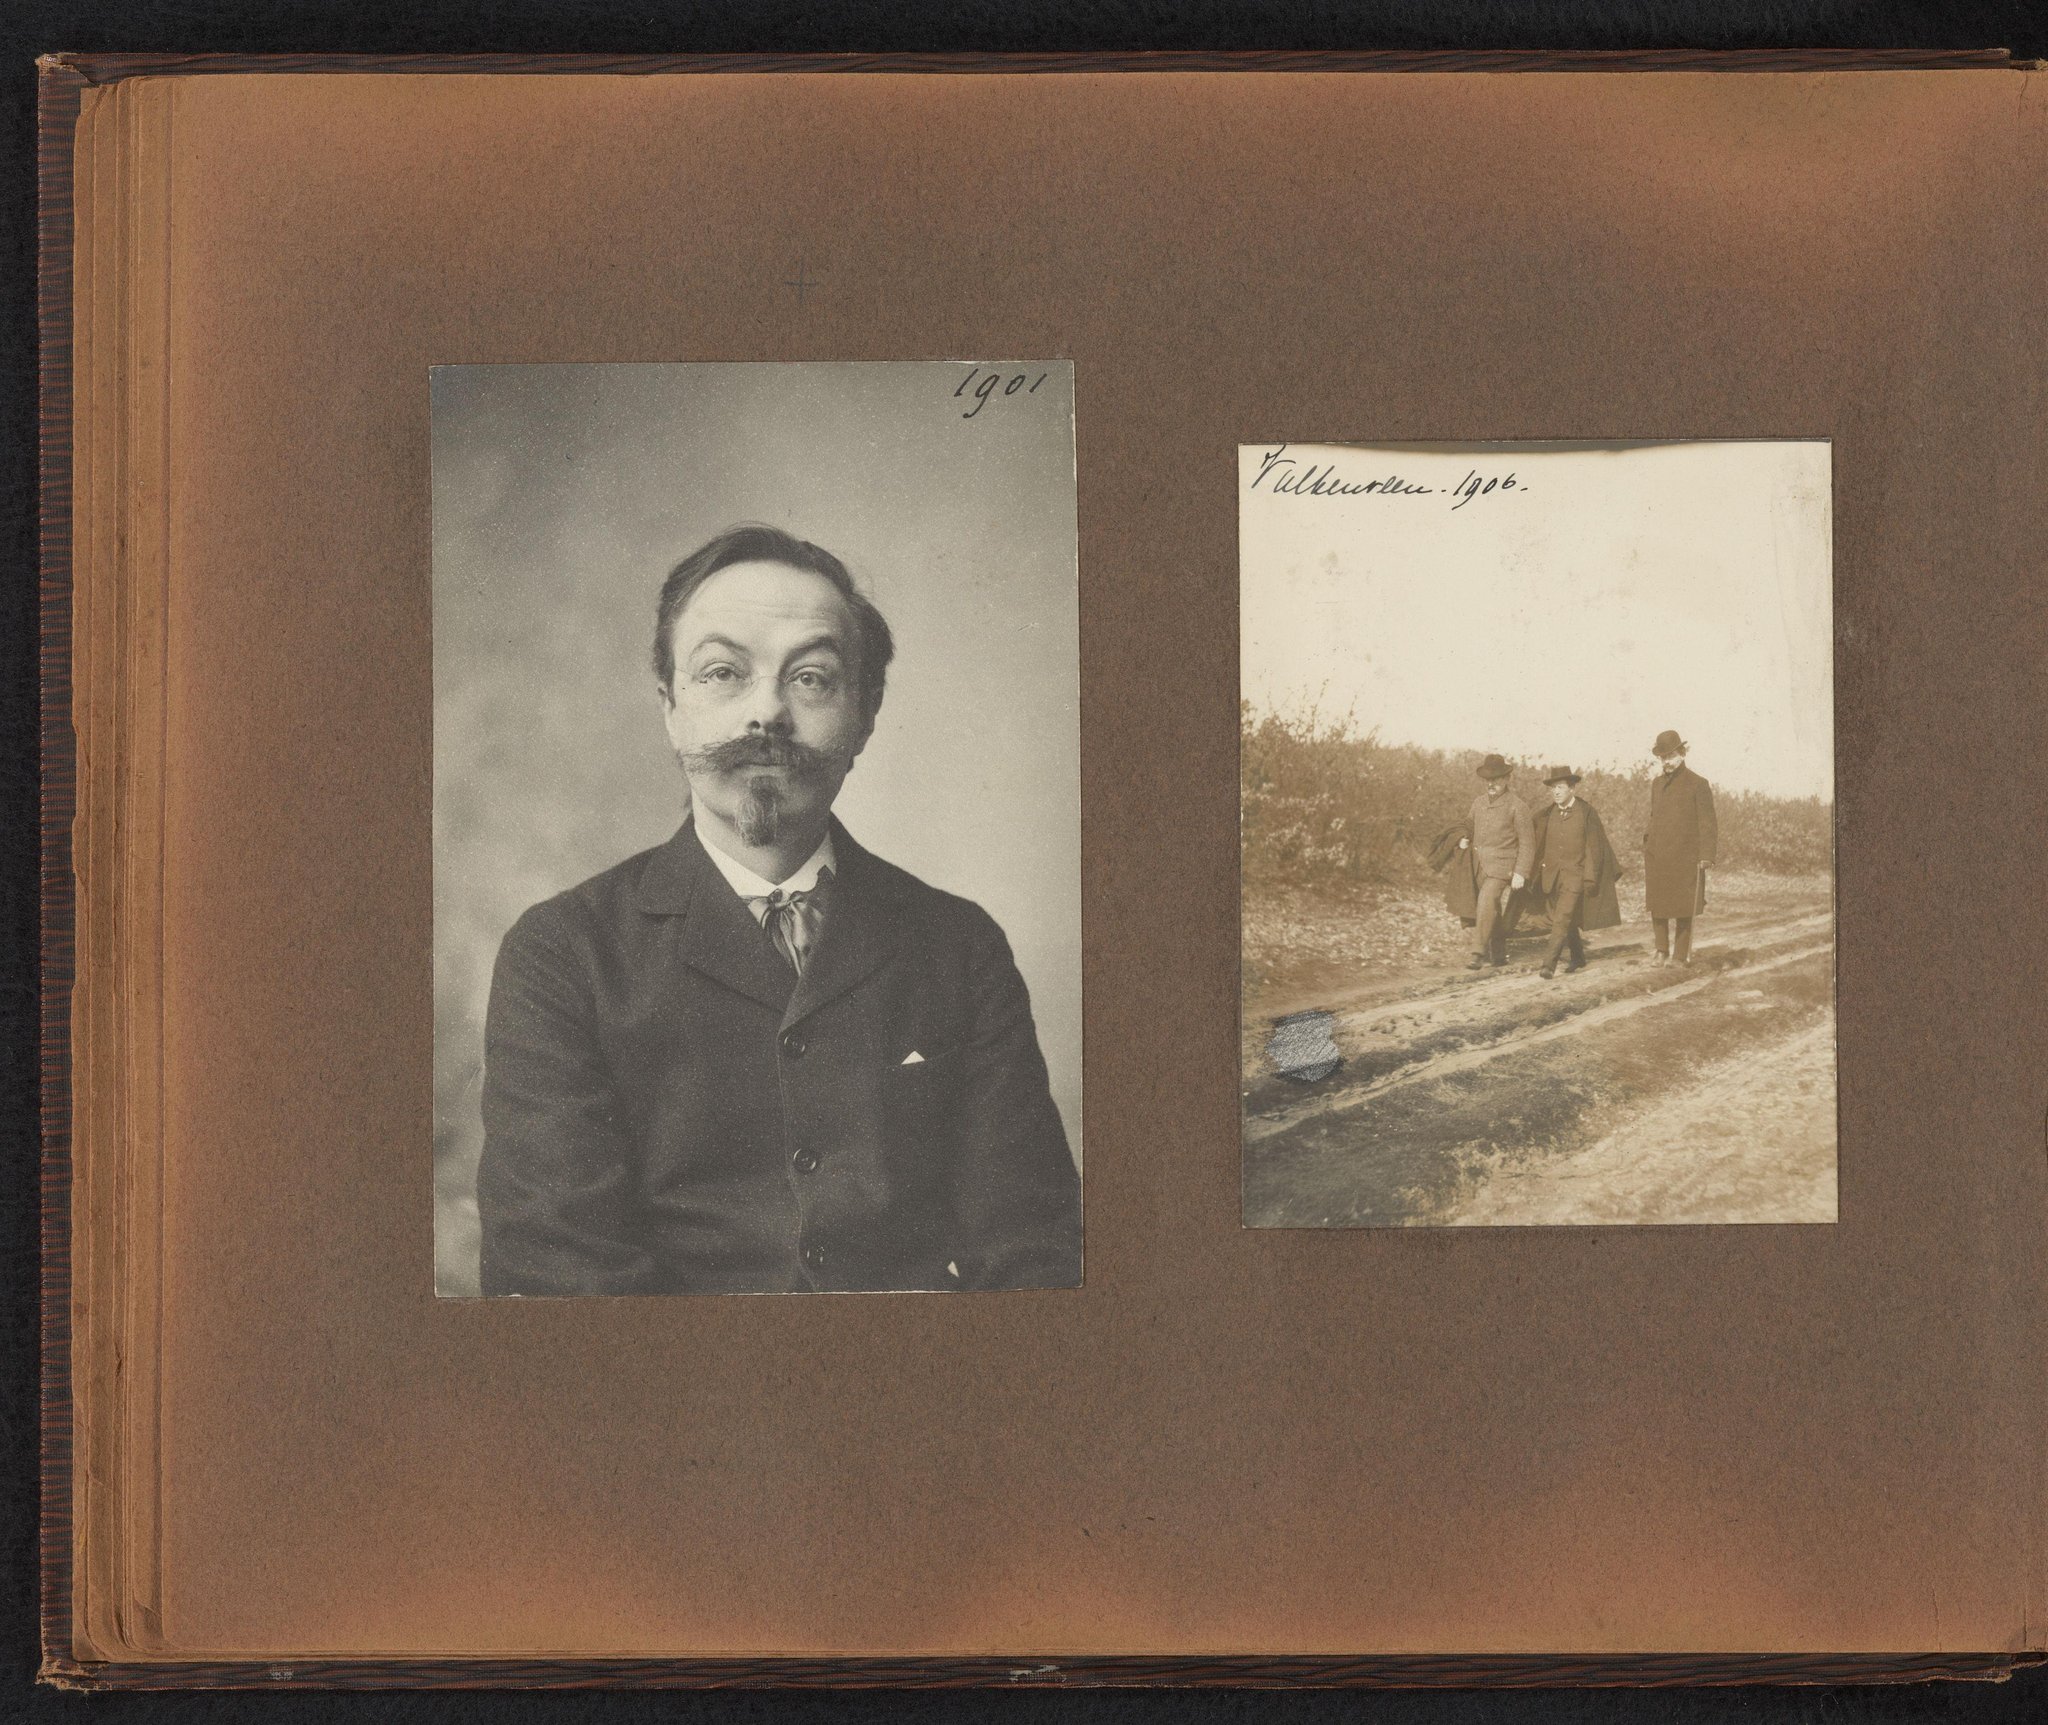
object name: album leaf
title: Bladzijde uit het fotoalbum van de familie Diepenbrock met 2 foto's van Alphons Diepenbrock en zijn omgeving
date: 1901-1906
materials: cardboard, photographic support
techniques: photography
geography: netherlands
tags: utrecht, amsterdam, alphons diepenbrock, vienna, gustav mahler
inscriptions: inscription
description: Bruin albumblad 14 van familiealbum van Alphons Diepenbrock.